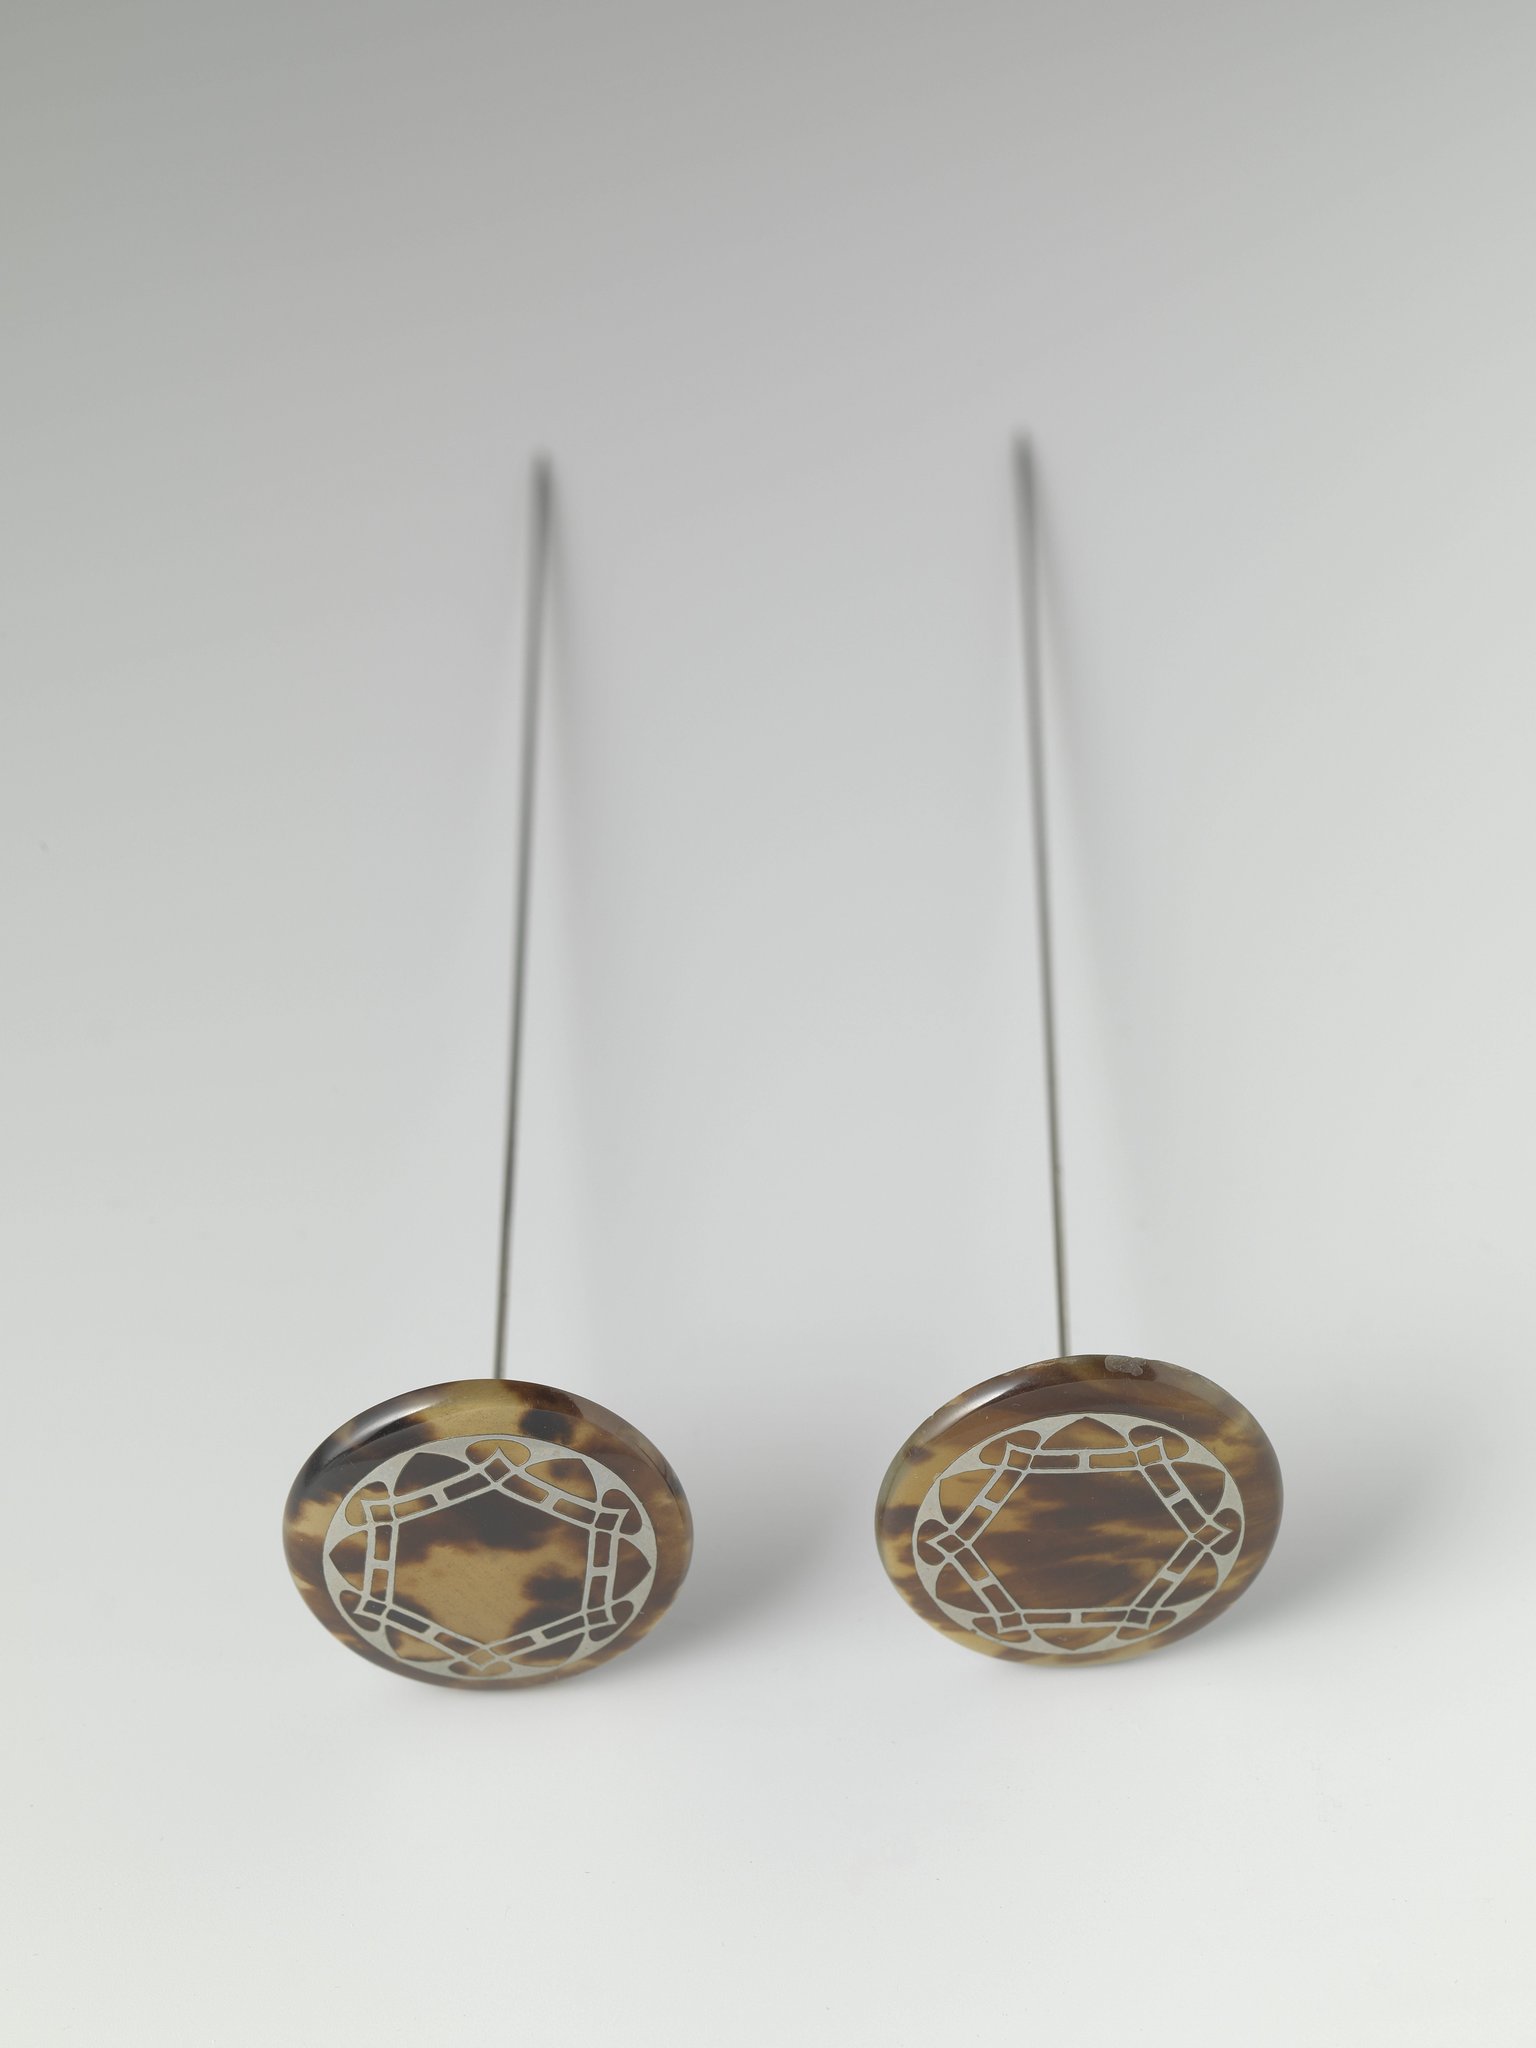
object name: hatpin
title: Hoedenspeld van imitatie-schildpad, ingelegd met wit metaal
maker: Anonymous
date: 1900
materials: tortoise shell, metal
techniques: cutting, forging, inlay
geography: netherlands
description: Hoedenspeld van imitatie-schildpad, ingelegd met wit metaal. Platte ronde knop met inlegwerk in een cirkel, waarin een zeshoek.